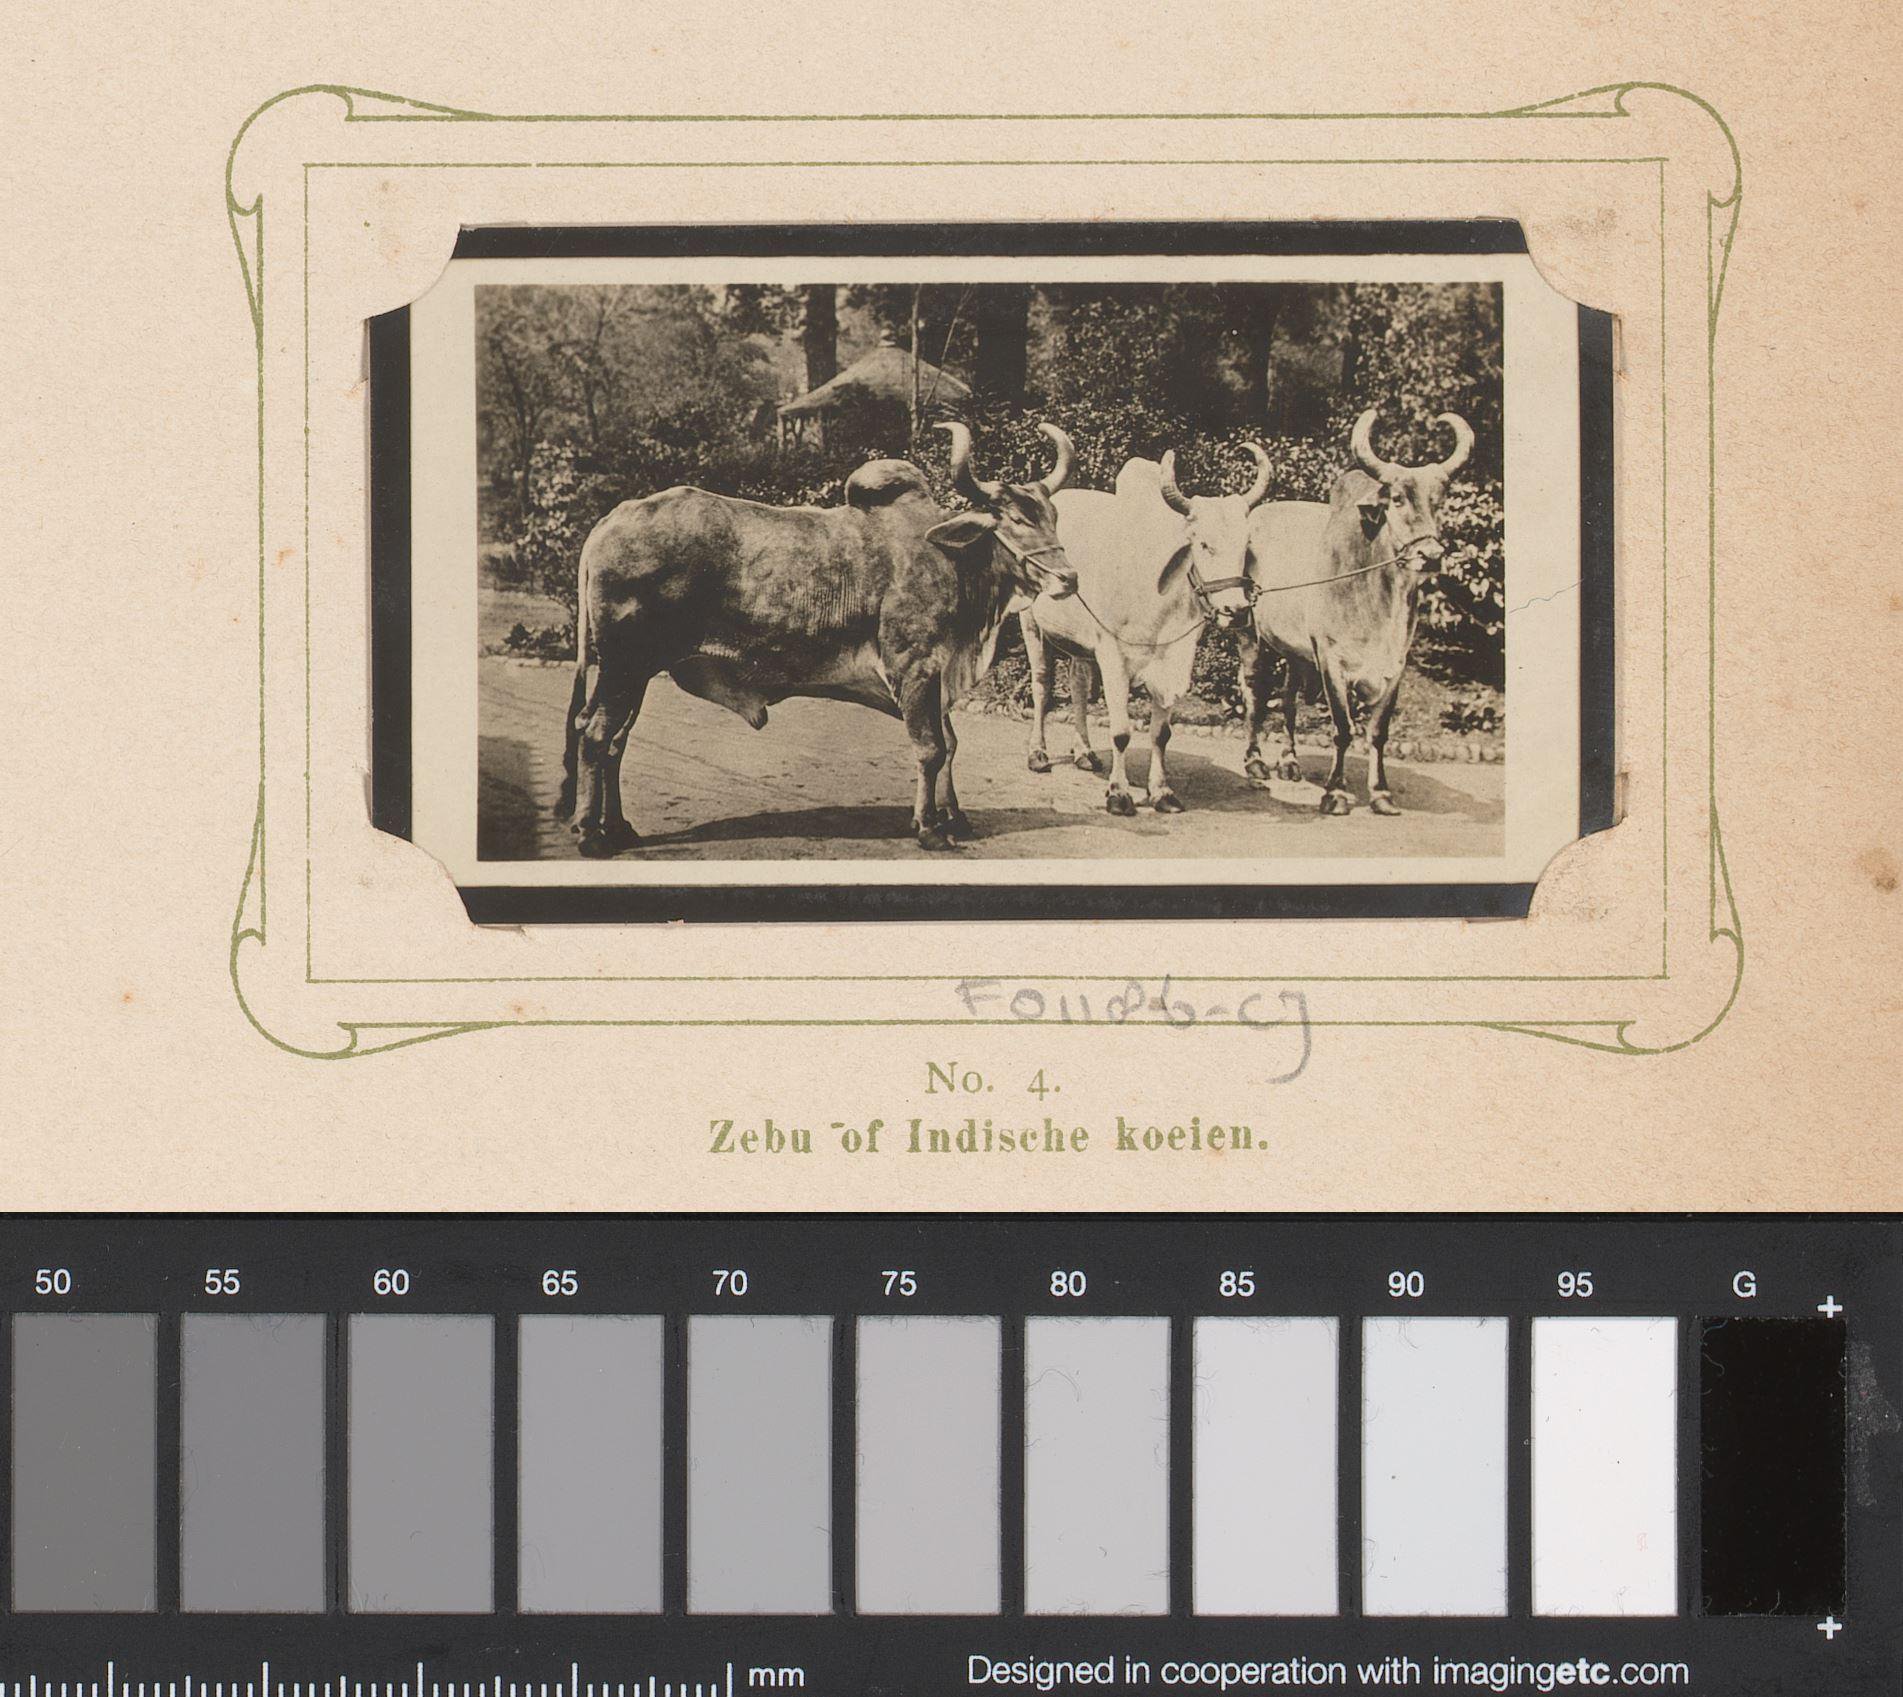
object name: album leaf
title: Drie zeboes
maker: Anonymous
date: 1904-1905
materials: photographic support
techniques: gelatin silver print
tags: hoofed animals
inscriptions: inscription: ‘No.4./ Zebu of Indische koeien.’